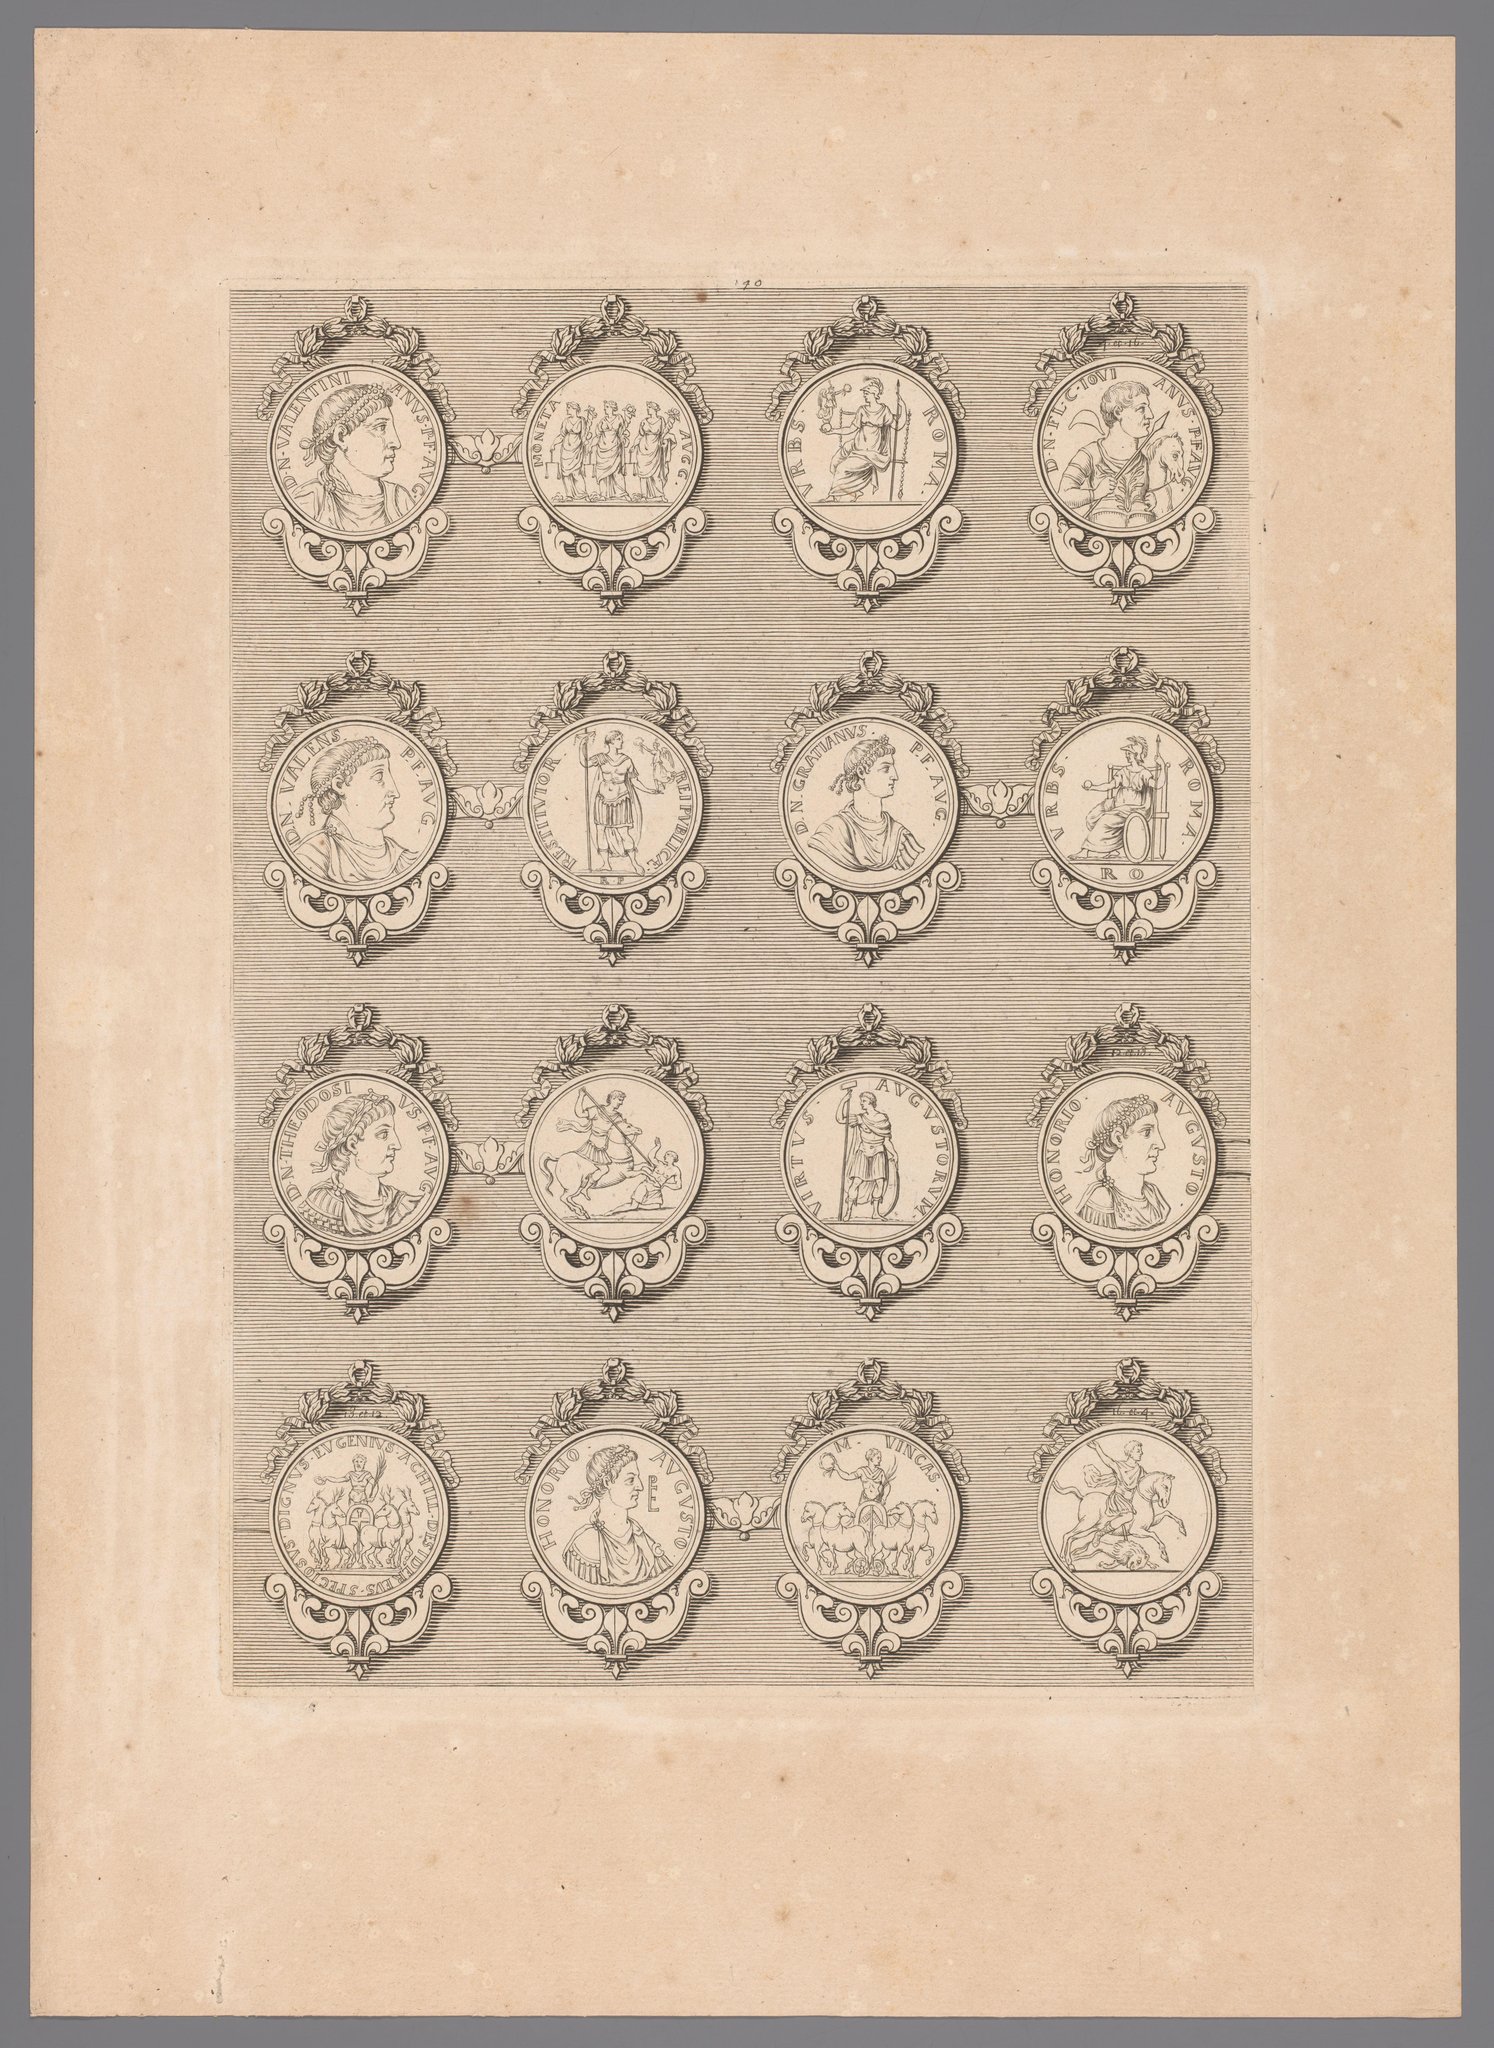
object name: print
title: Zestien penningen met versierde lijsten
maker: simon de la boissière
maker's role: print maker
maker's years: 1637-1682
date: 1647-1682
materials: paper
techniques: etching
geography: france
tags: medal (considered as a piece of sculpture, regardless of its specific function)